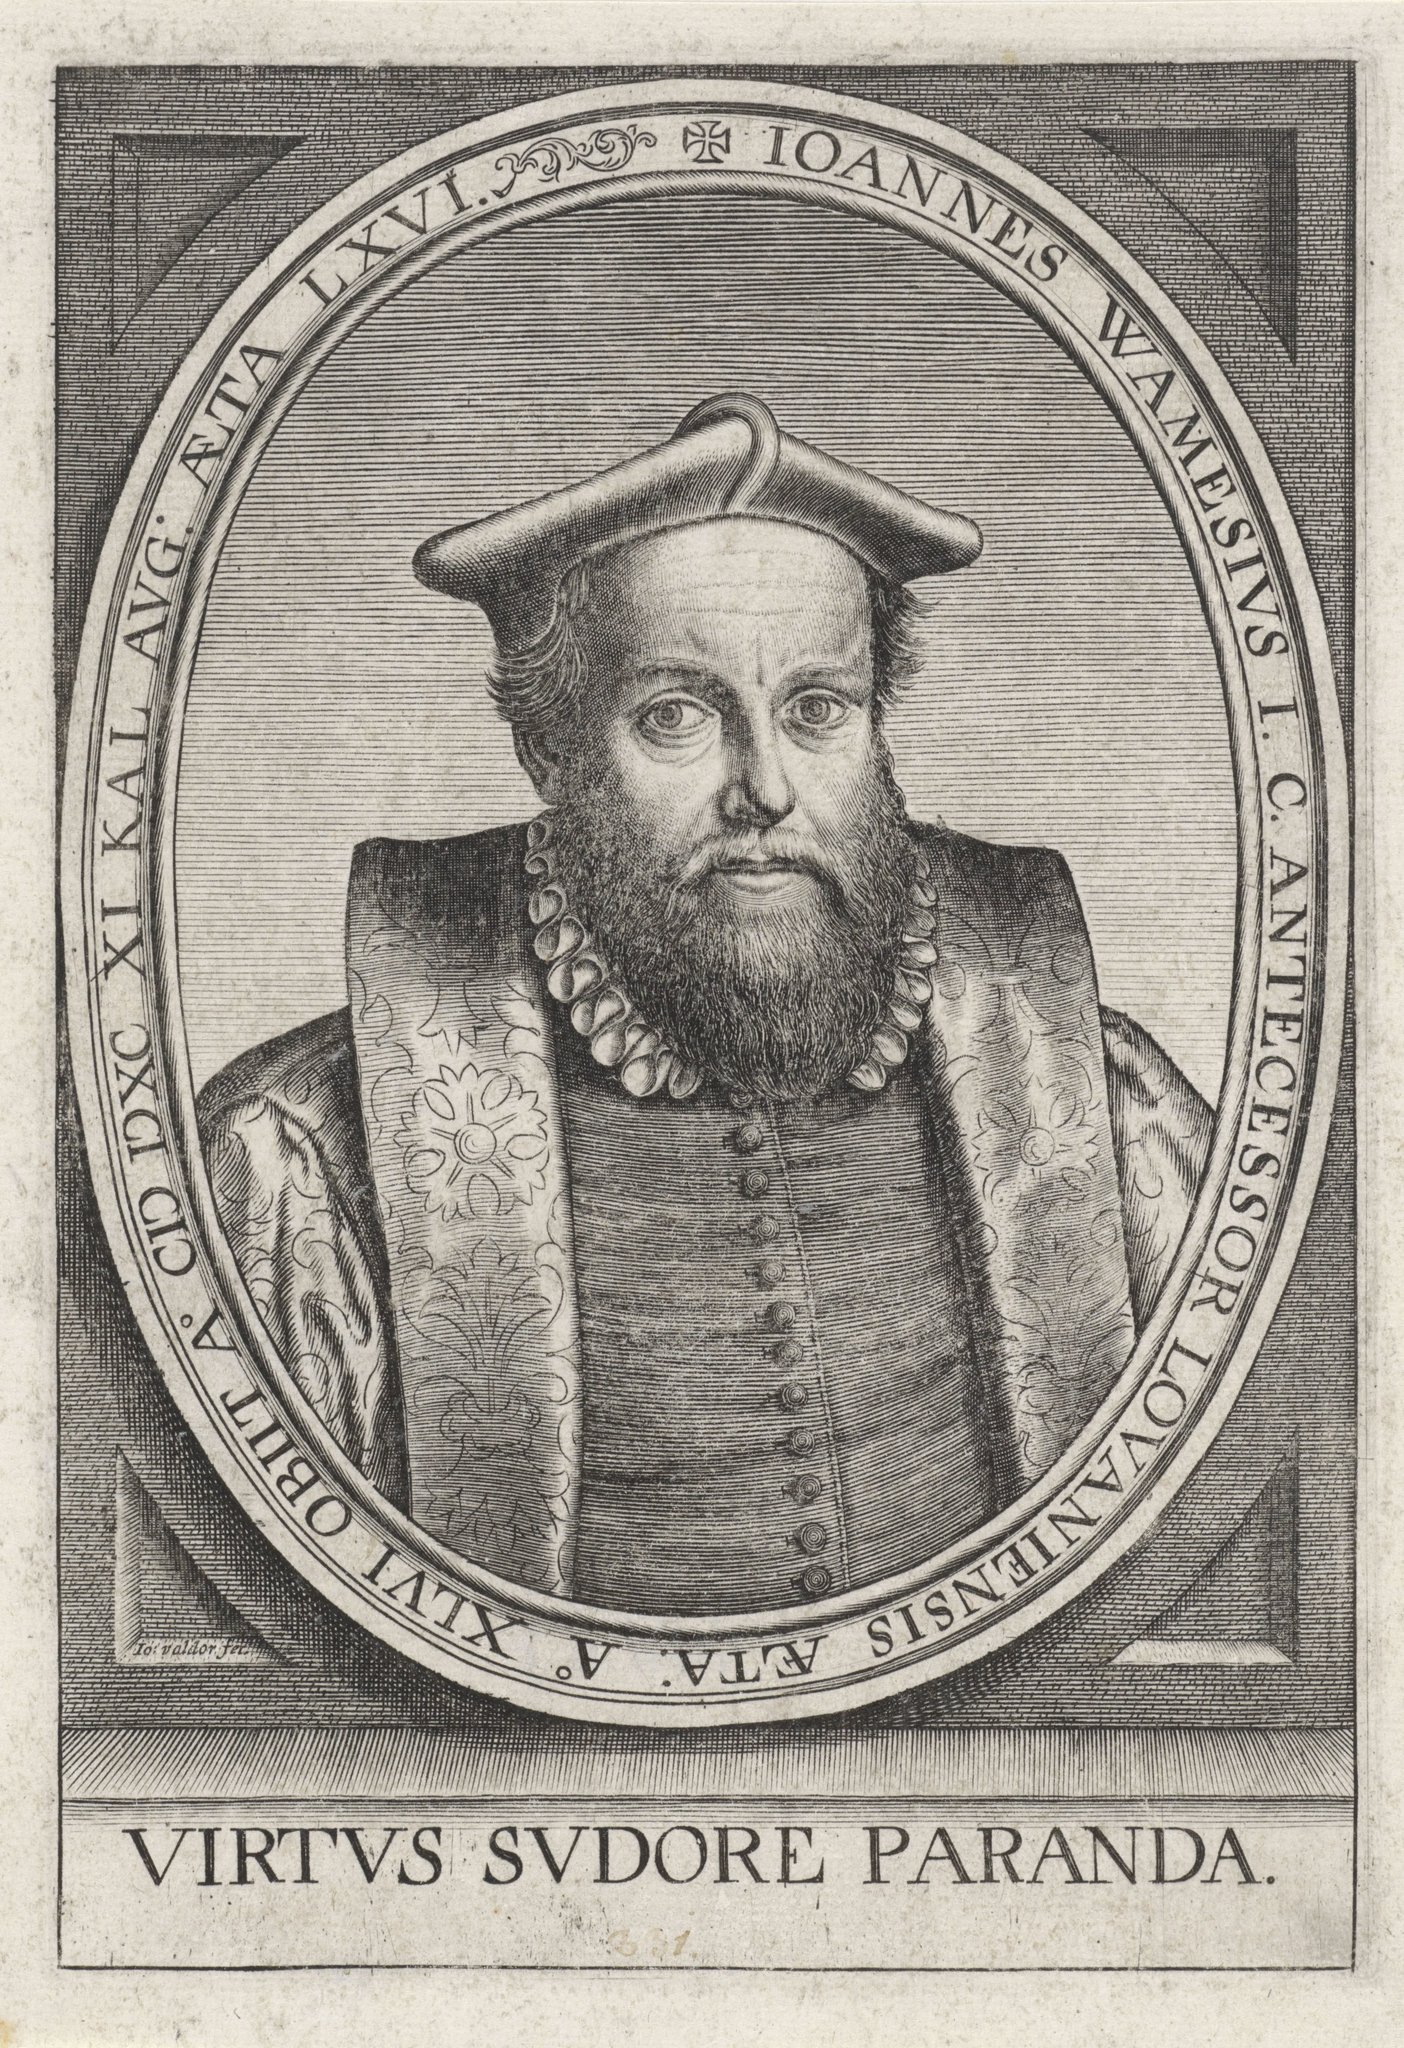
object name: print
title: Portret van Johannes Wamesius op 46-jarige leeftijd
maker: johannes valdor (i)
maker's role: print maker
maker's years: 1580-1640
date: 1639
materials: paper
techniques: engraving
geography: southern netherlands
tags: louvain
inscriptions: collector's mark: Lugt 2228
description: Prent ook gebruikt in: Wamesius, J. Responsorvm sive consiliorvm ad ivs forvmqve civile pertinentivm, centvria prima (-secvnda). Antwerpen: Hendrik Aertssens I, 1639-1641.